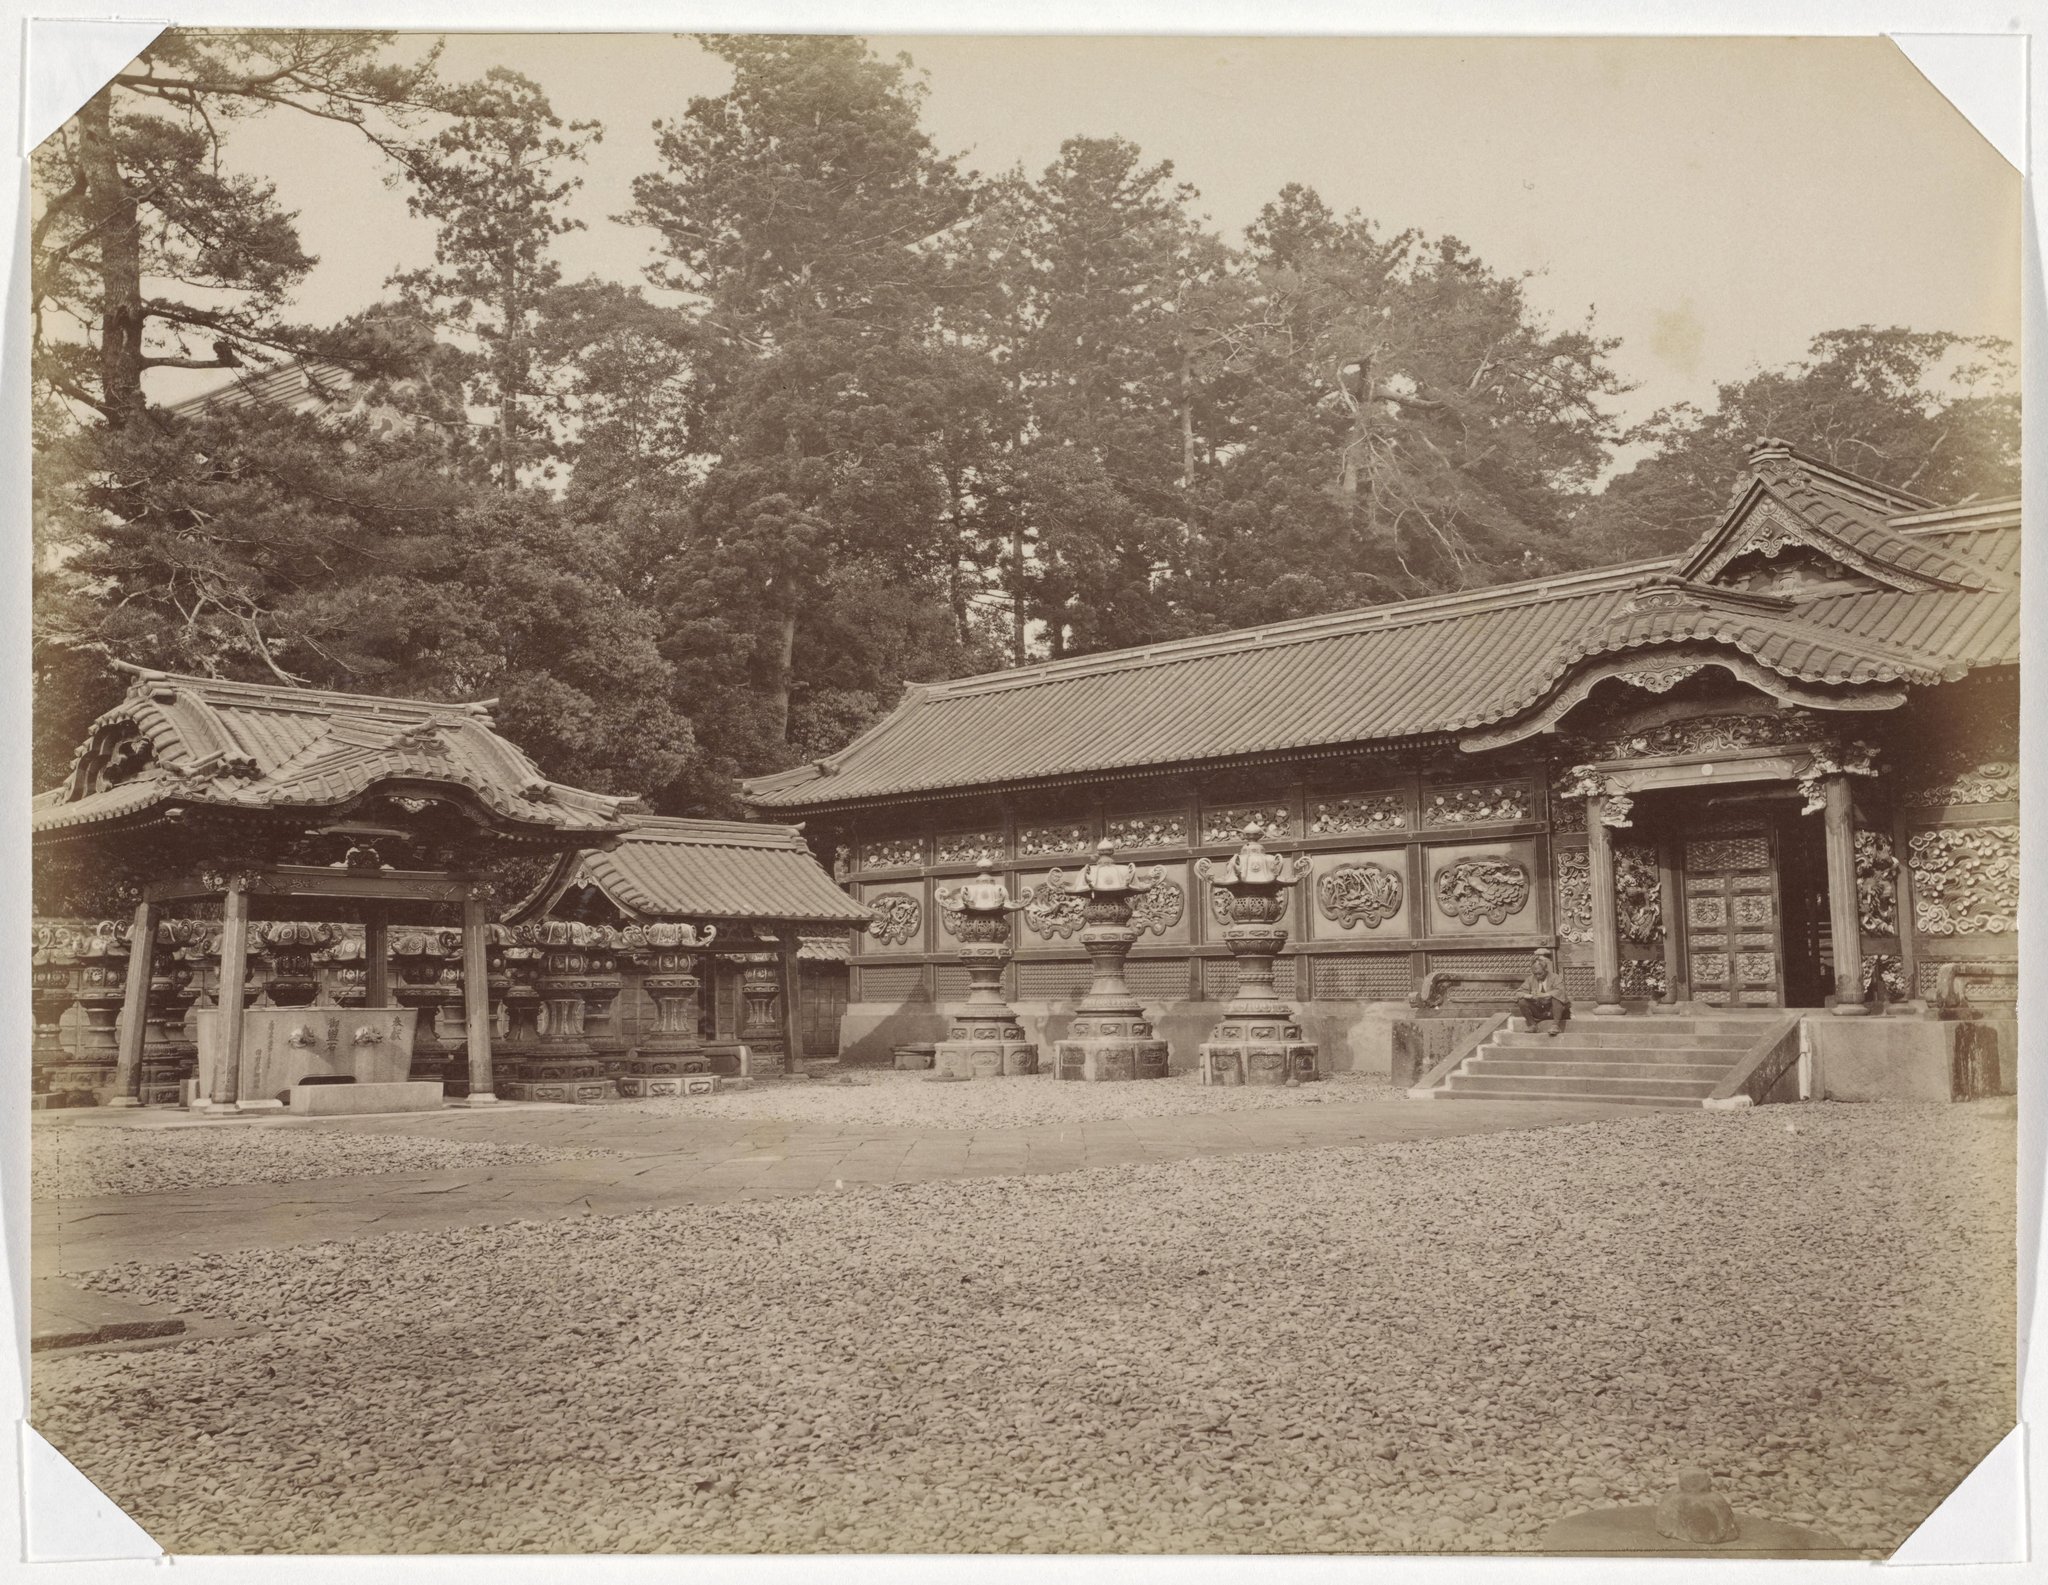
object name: photograph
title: Exterieur van de Shiba-tempel in Tokyo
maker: Anonymous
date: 1890-1894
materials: cardboard, paper, photographic support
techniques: albumen print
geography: tokyo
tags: temple, shrine ~ hinduism, buddhism, jainism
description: Onderdeel van Album met 69 foto's van een reis door Japan.